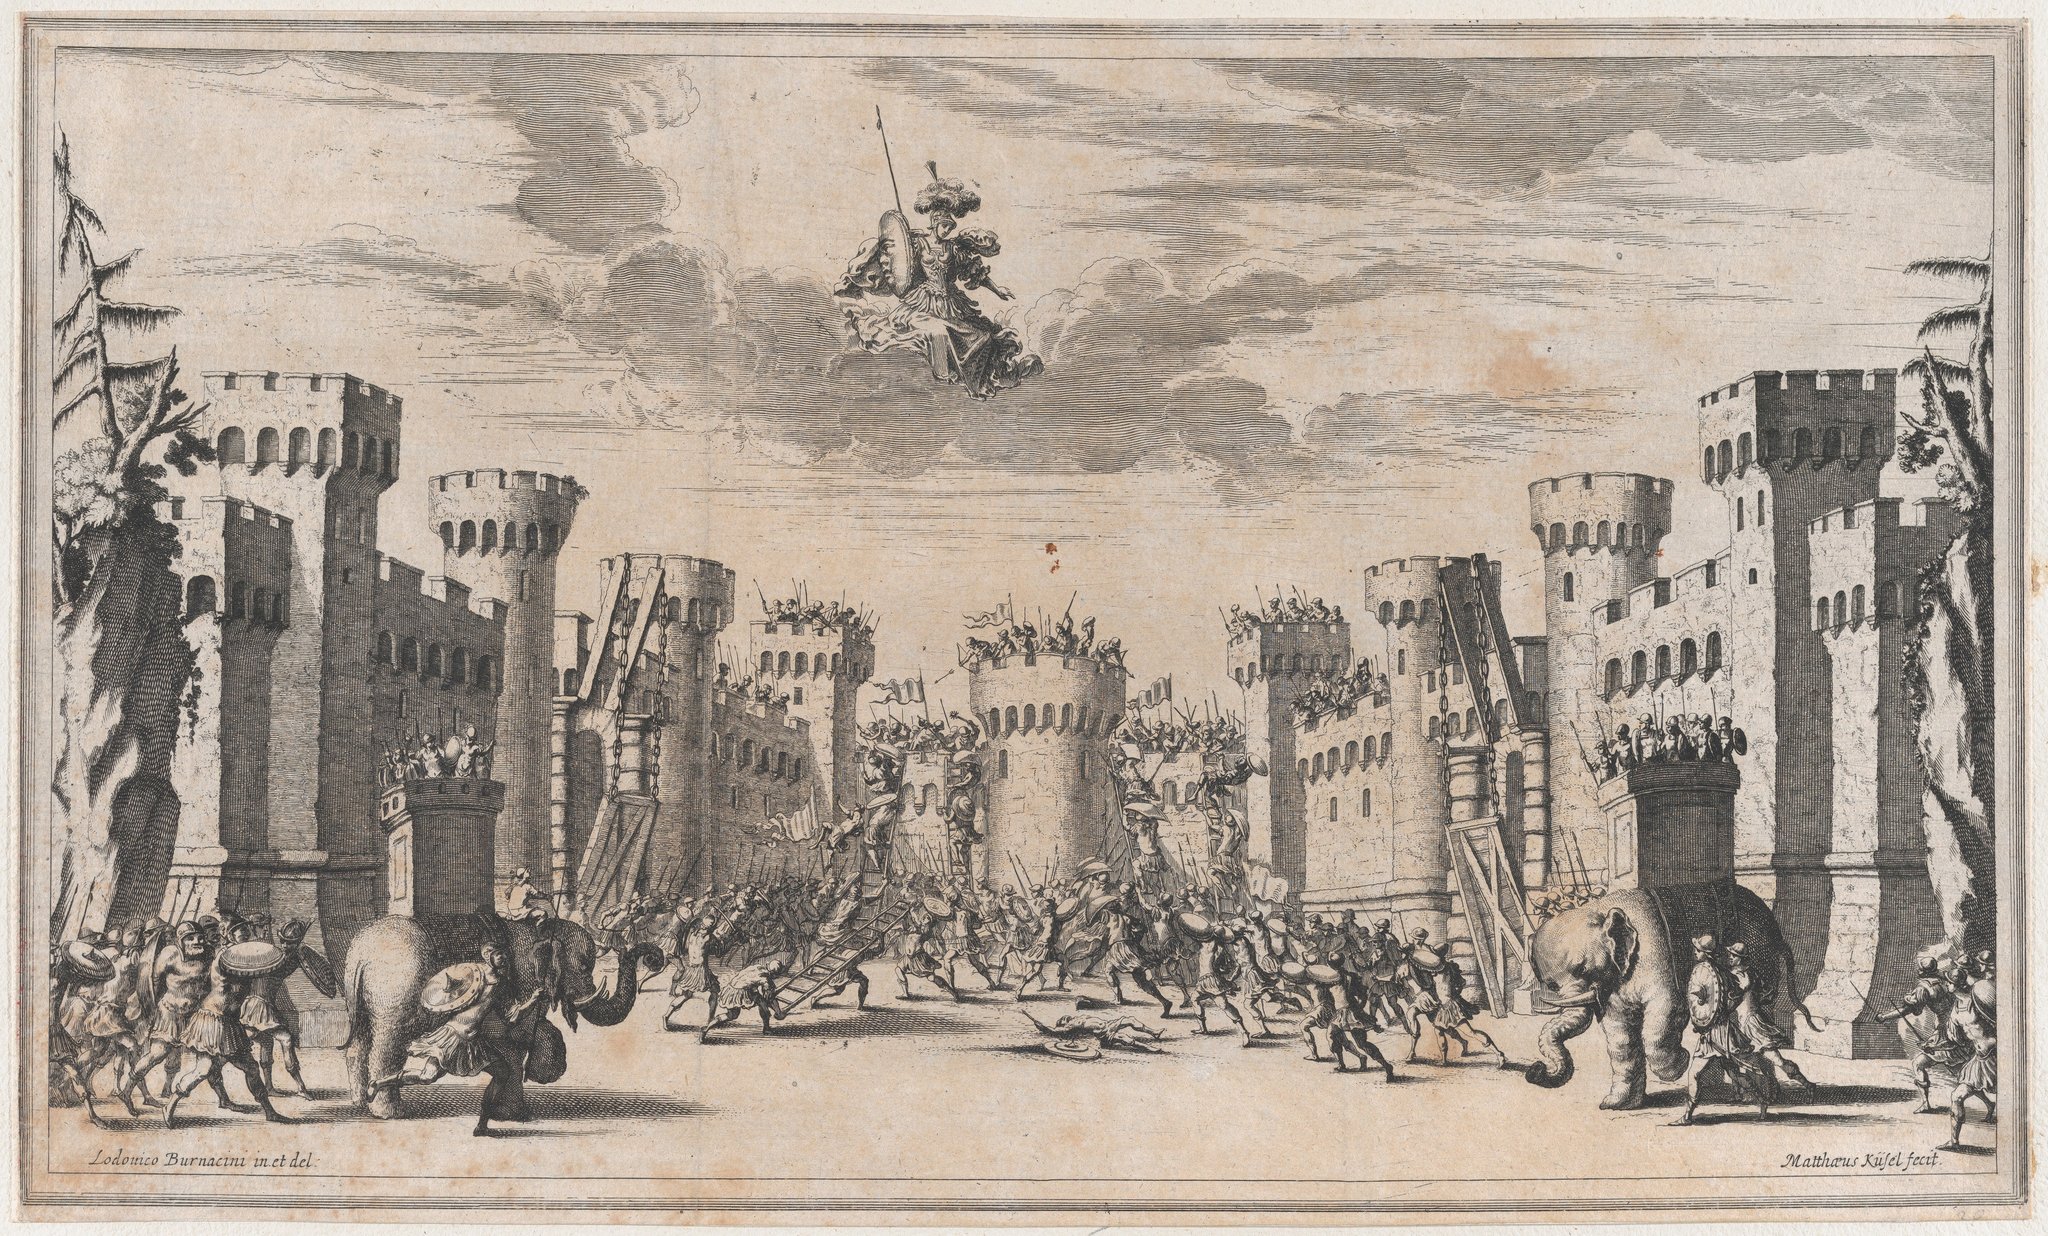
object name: print, fete, ornament architecture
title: A city under siege with elephants and soldiers throughout; Mars looking down from above; set design from 'Il Pomo D'Oro'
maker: mathäus küsel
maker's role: artist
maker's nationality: german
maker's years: 1621-1682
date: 1668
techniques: etching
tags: fortification,battles,soldiers,mars,elephants